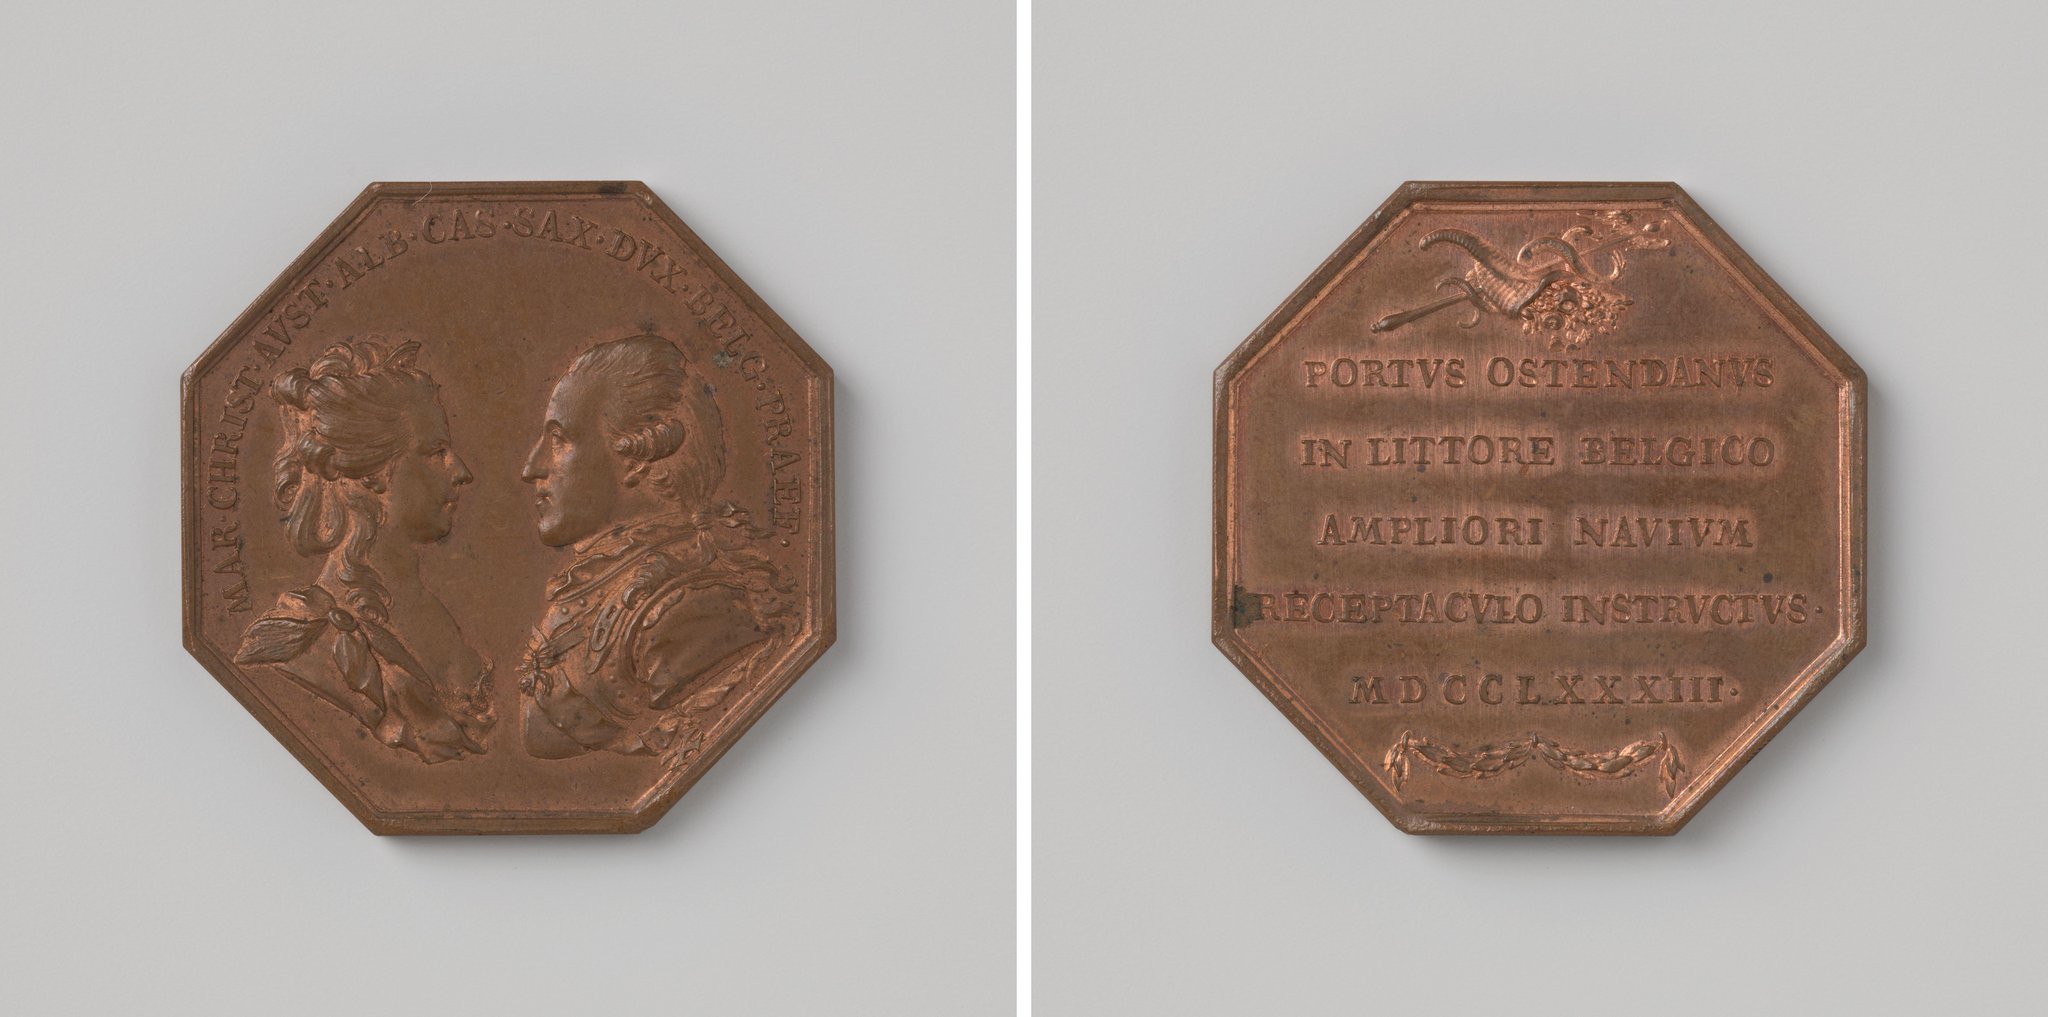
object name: history medal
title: Vergrooting van de haven van Oostende, ter ere van Maria Christina en Albert-Kasimir, landvoogden der zuidelijke Nederlanden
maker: Anonymous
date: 1783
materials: bronze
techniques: striking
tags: vienna, albert casimir van saksen-teschen, maria christina van oostenrijk (1742-1798)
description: Bronzen achthoekige penning. Voorzijde: naar elkaar gewende borststukken van man en vrouw binnen omschrift. Keerzijde: opschrift onder gevulde hoorn van overvloed, Mercuriusstaf en degen, boven guirlande.